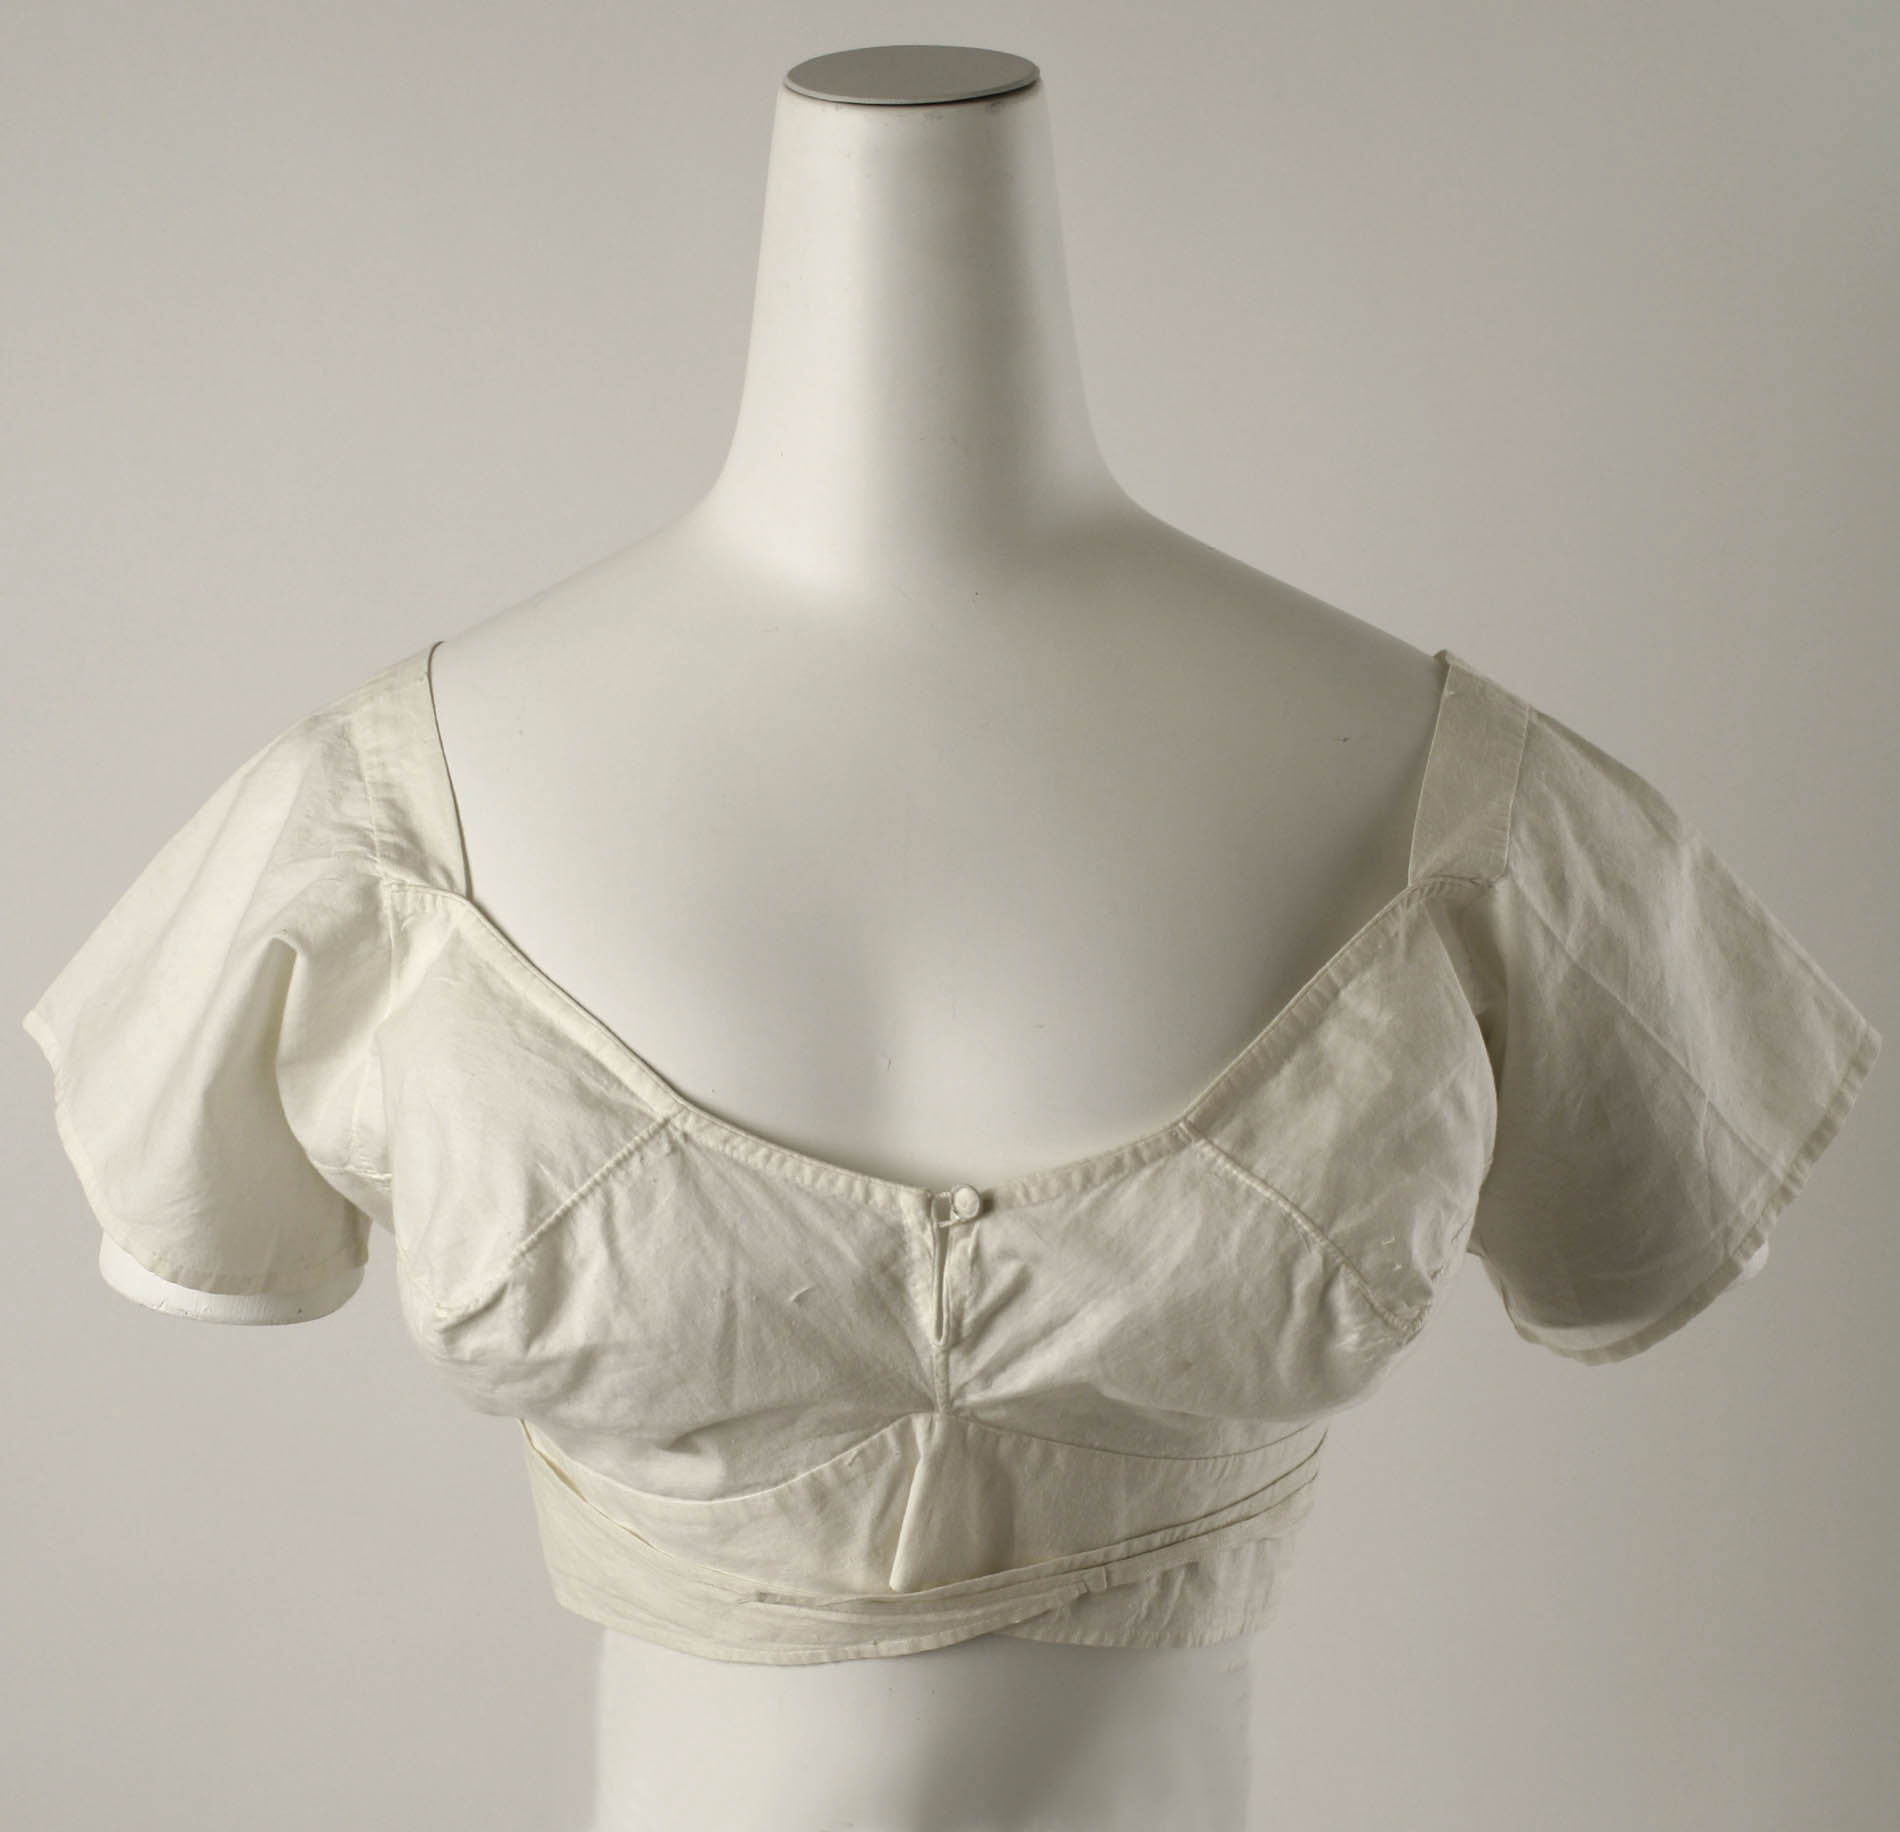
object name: brassiere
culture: american or european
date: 1820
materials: cotton